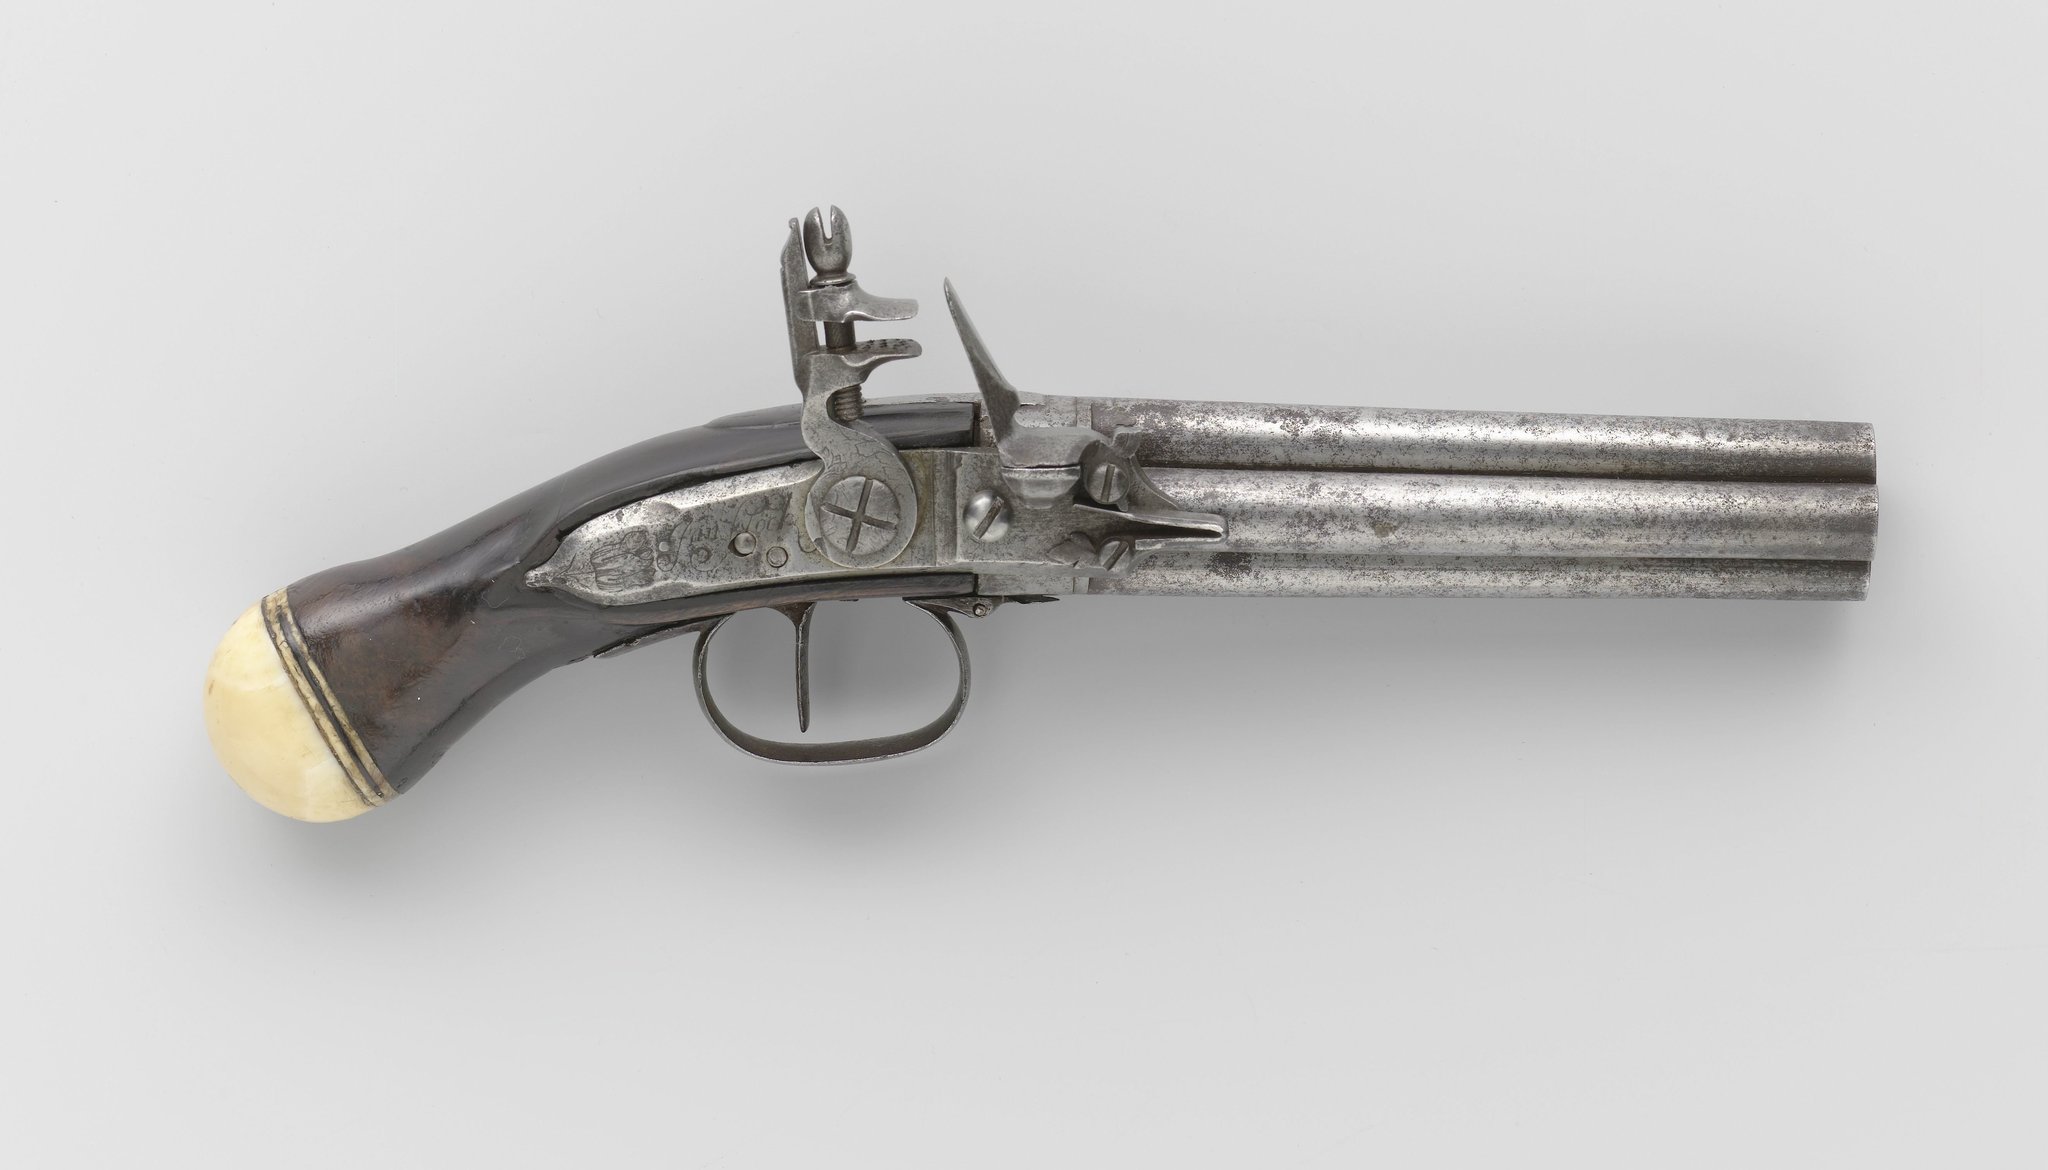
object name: pocket pistol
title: Vierloops vuursteendraailoopzakpistooltje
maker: jan flock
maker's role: geweermaker, pistoolmaker, smid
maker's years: -1688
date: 1650-1655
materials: iron, ivory, wood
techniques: engraving, soldering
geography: utrecht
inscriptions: signature: ‘Jan flock’